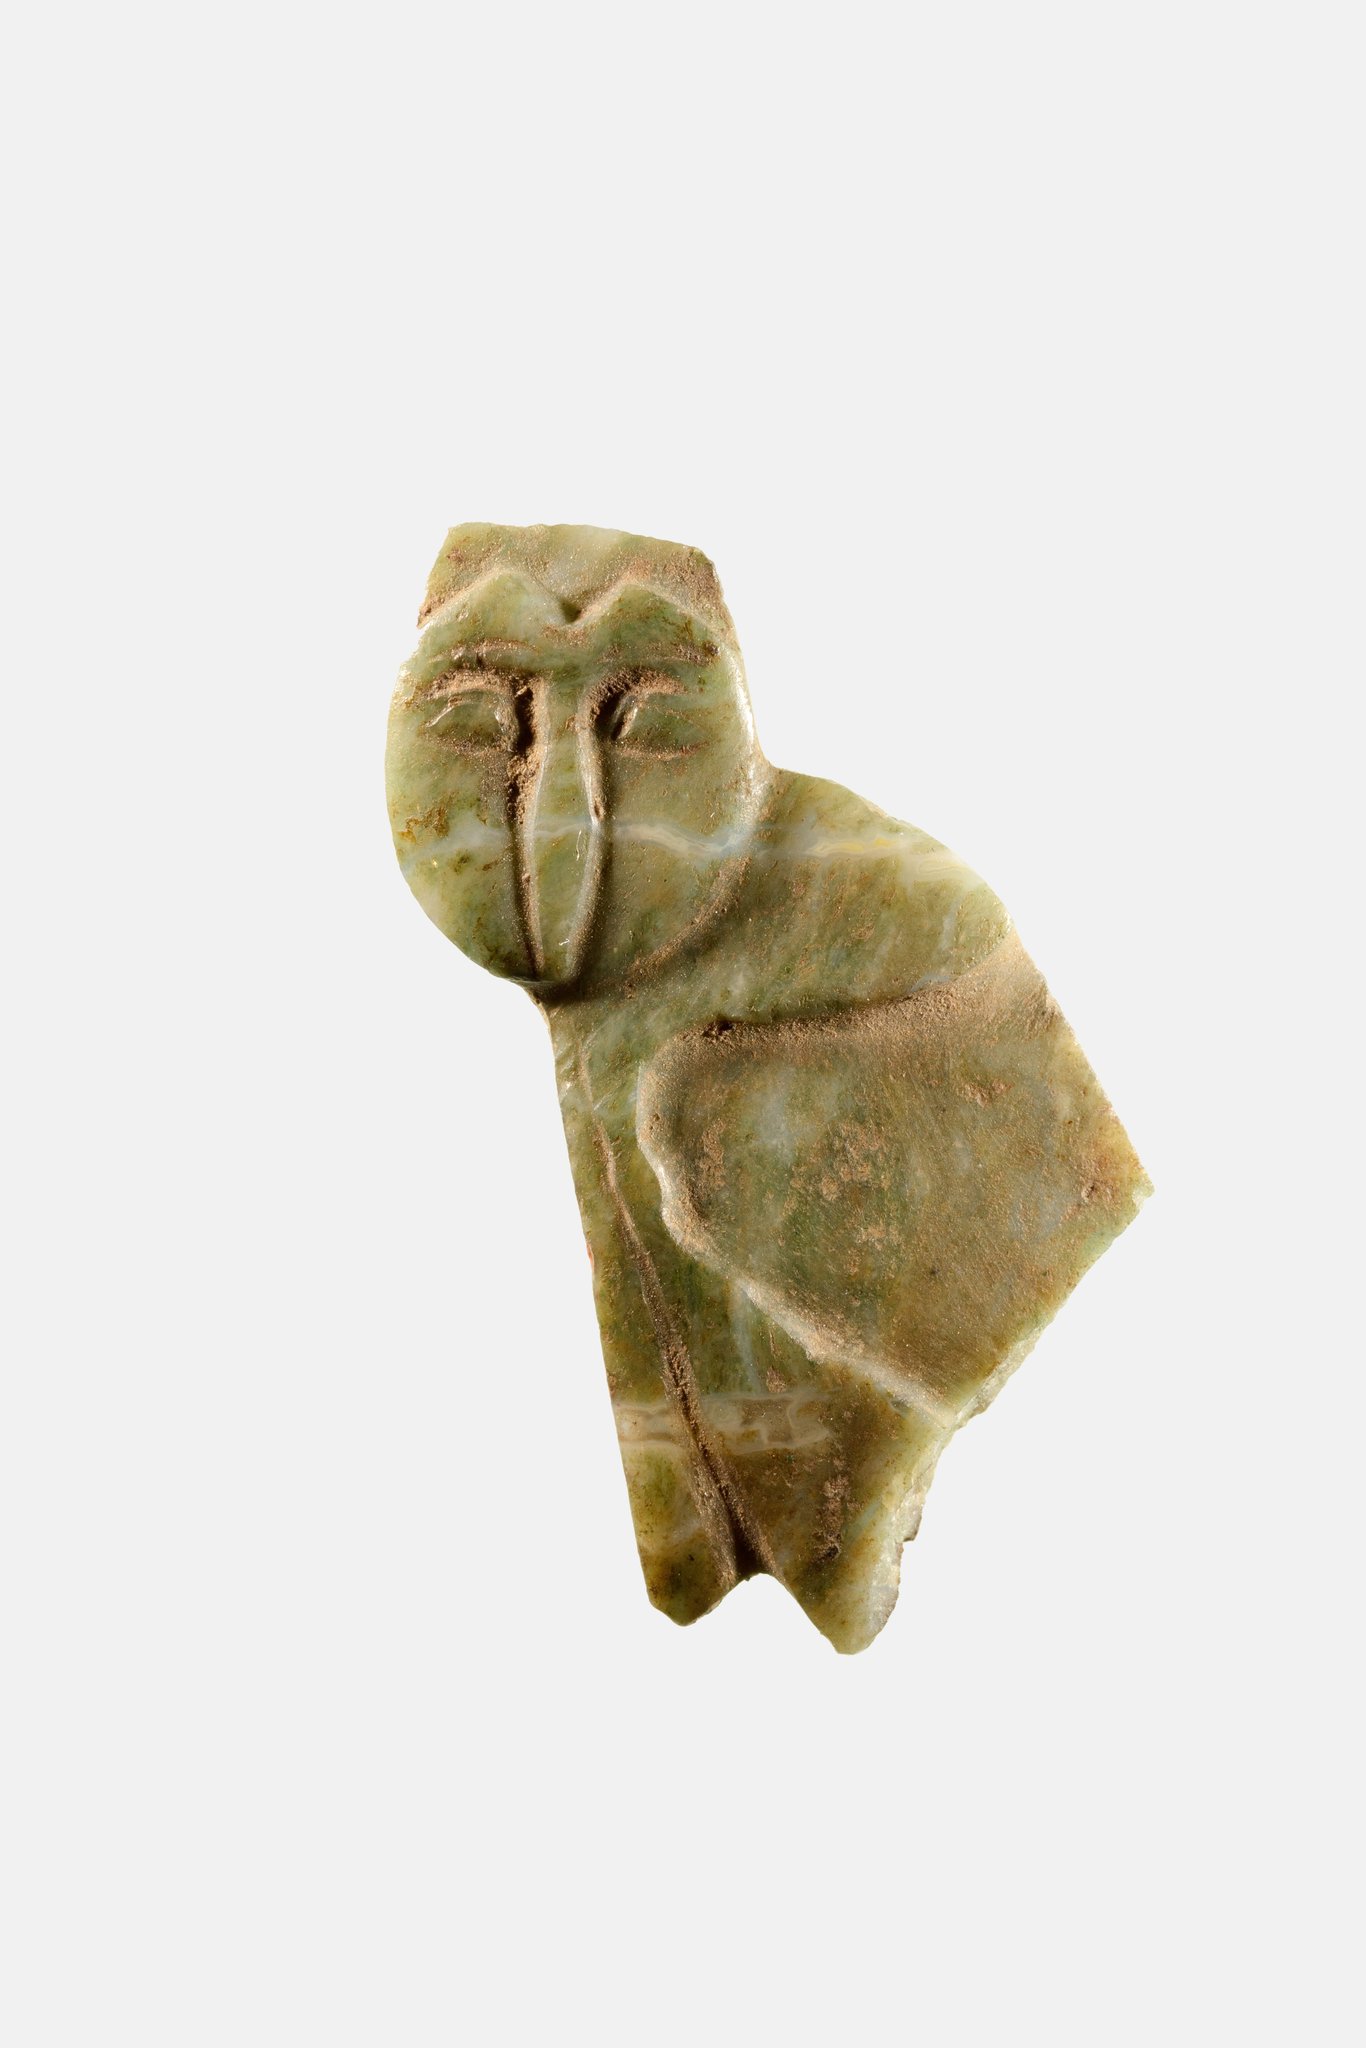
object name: inlay, owl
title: Owl Hieroglyph Inlay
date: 1550-1295 BCE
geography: northern upper egypt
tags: owls